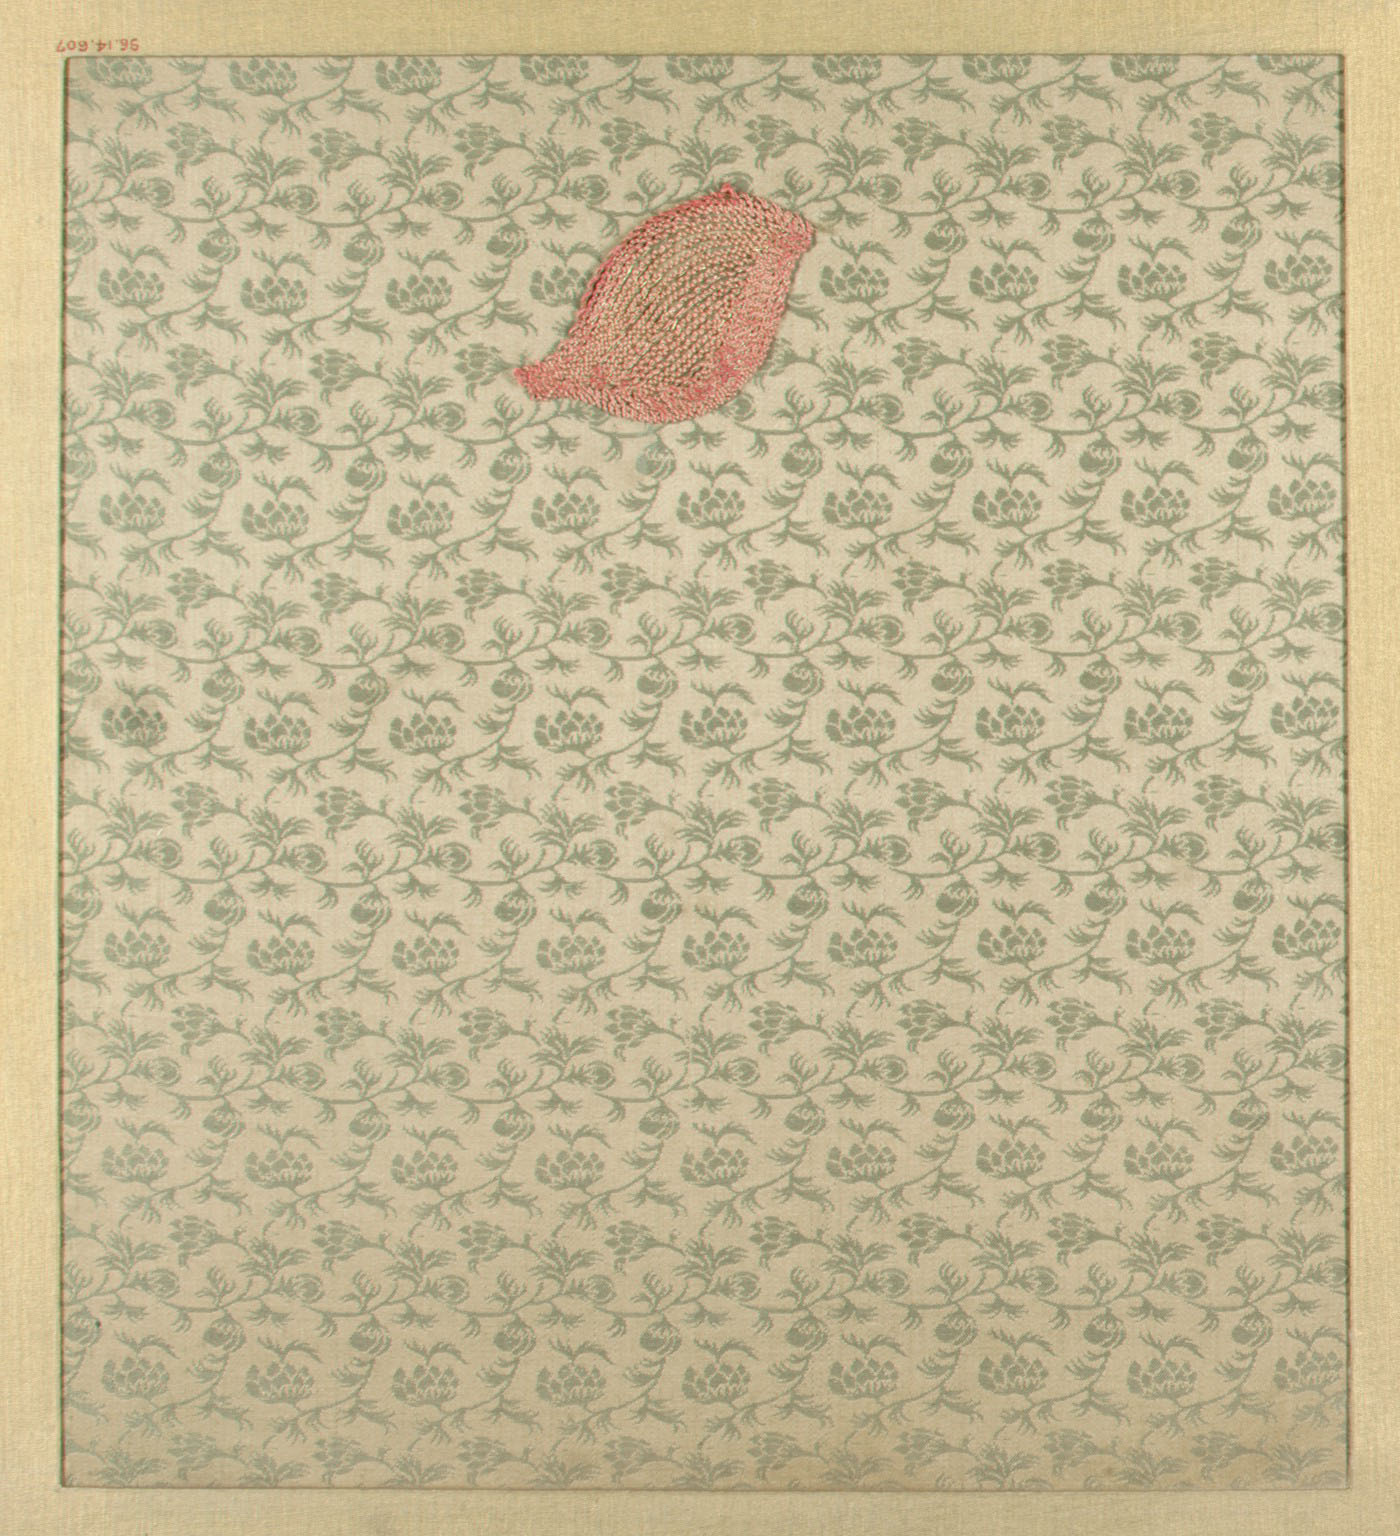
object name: piece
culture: japanese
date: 1701-1900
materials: silk